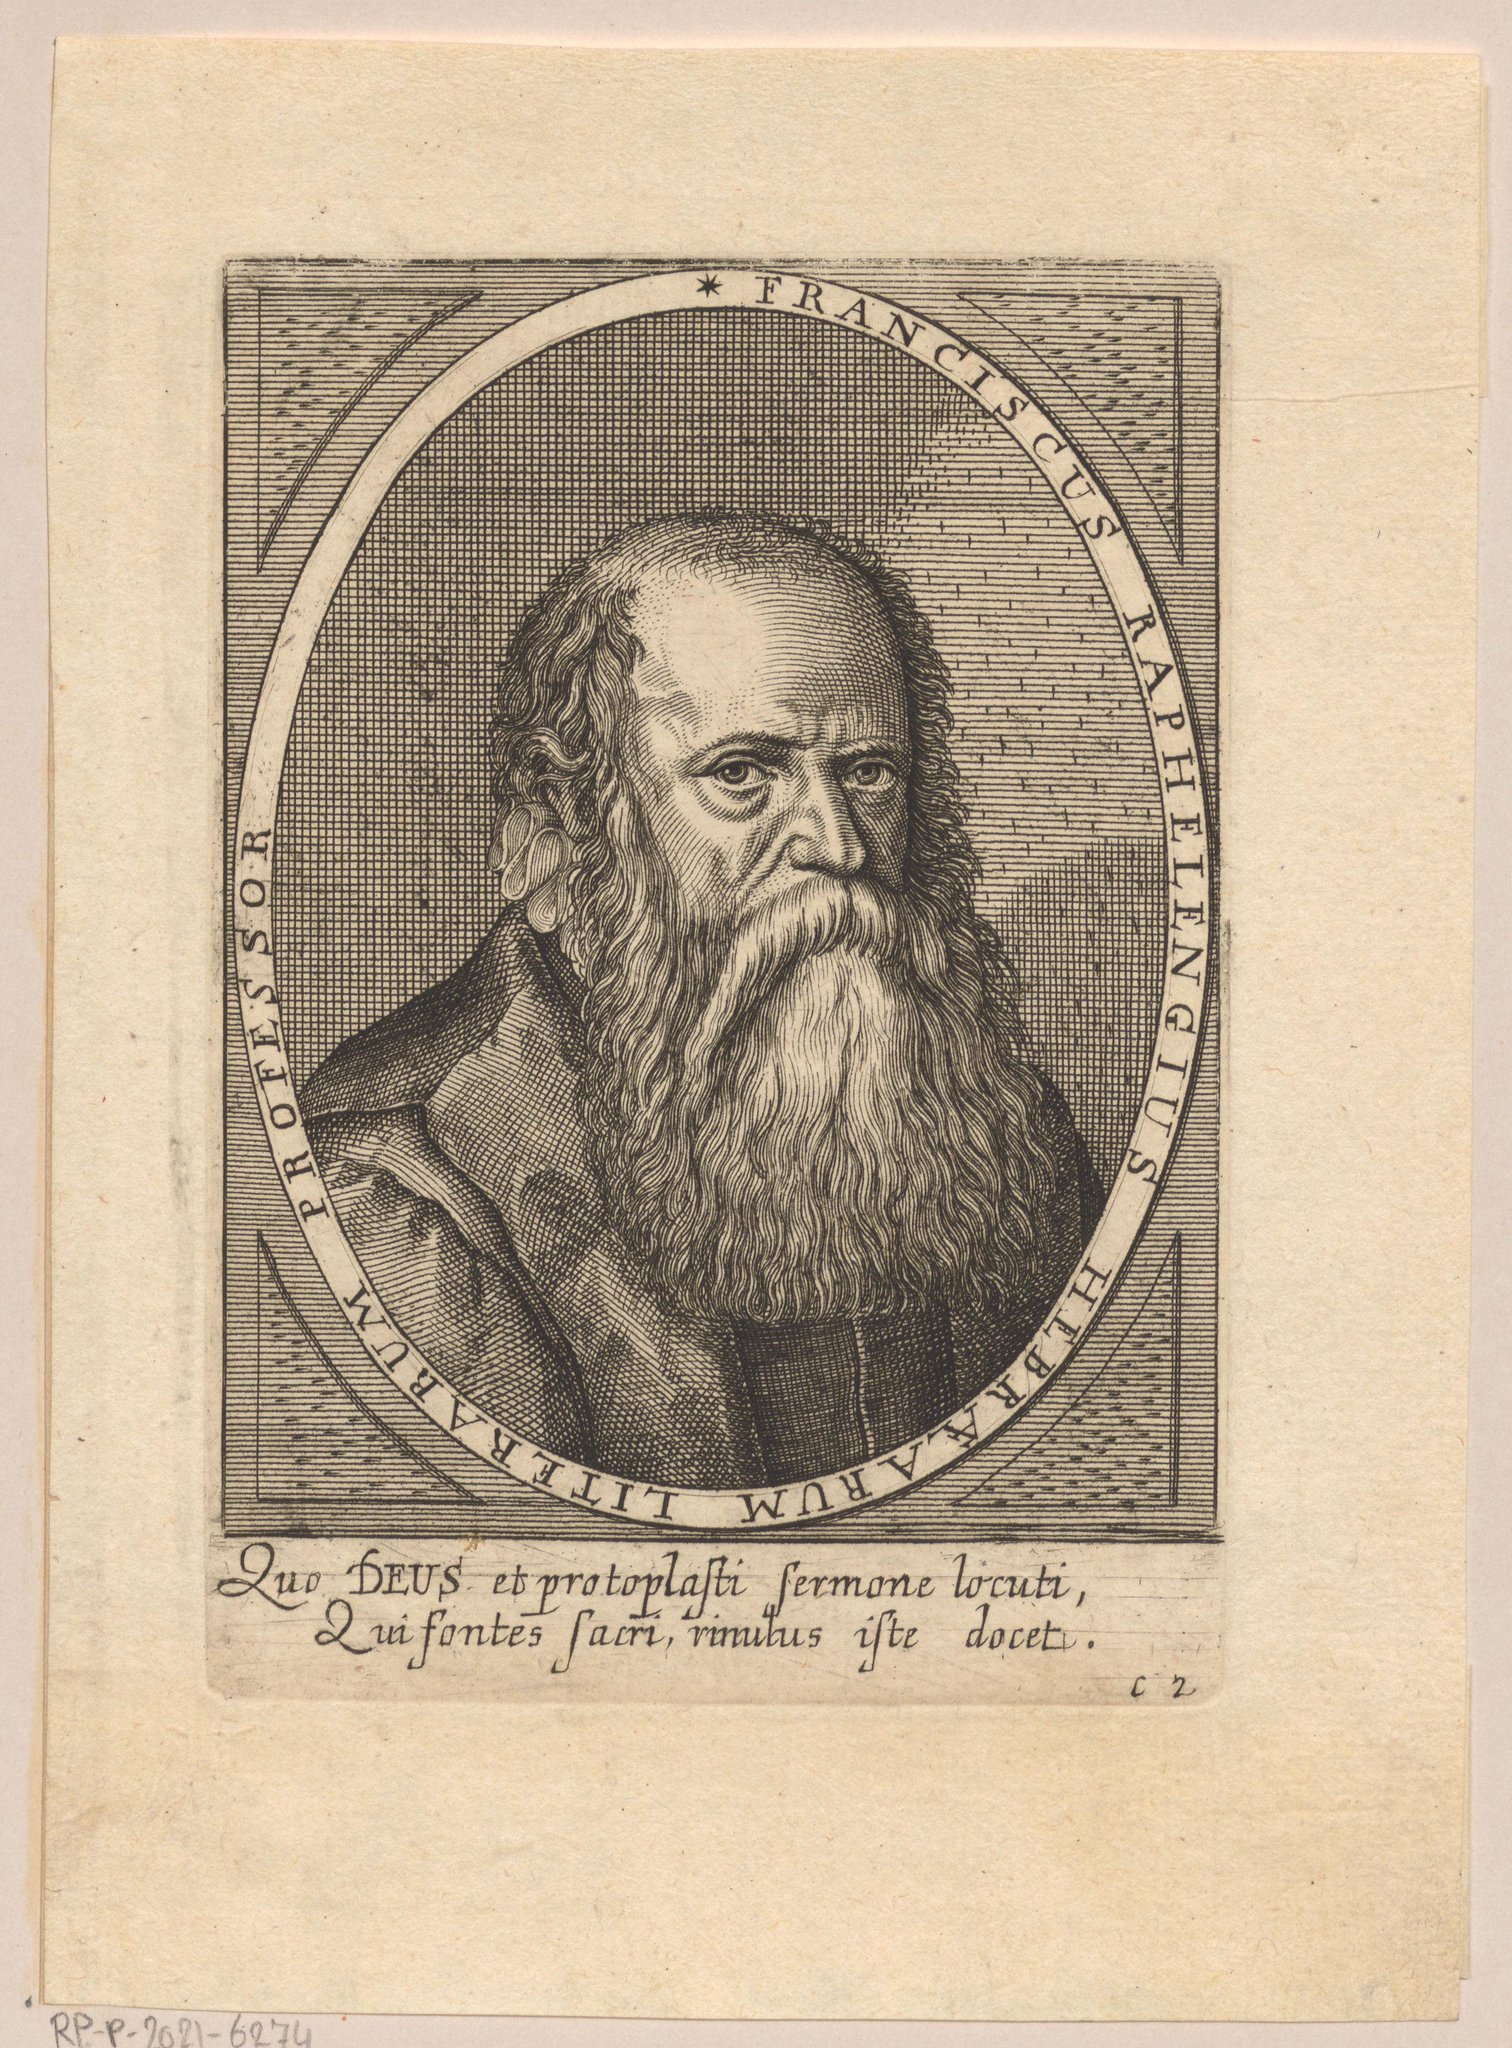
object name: print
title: Portret van Franciscus Raphelengius I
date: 1650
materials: paper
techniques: engraving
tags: france, leiden, franciscus raphelengius (i), historical persons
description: Prent waarschijnlijk uit: Boissard, Jean Jacques. Bibliotheca chalcographica (...). Frankfurt am Main: Johannes Ammon, 1650, dl. II.